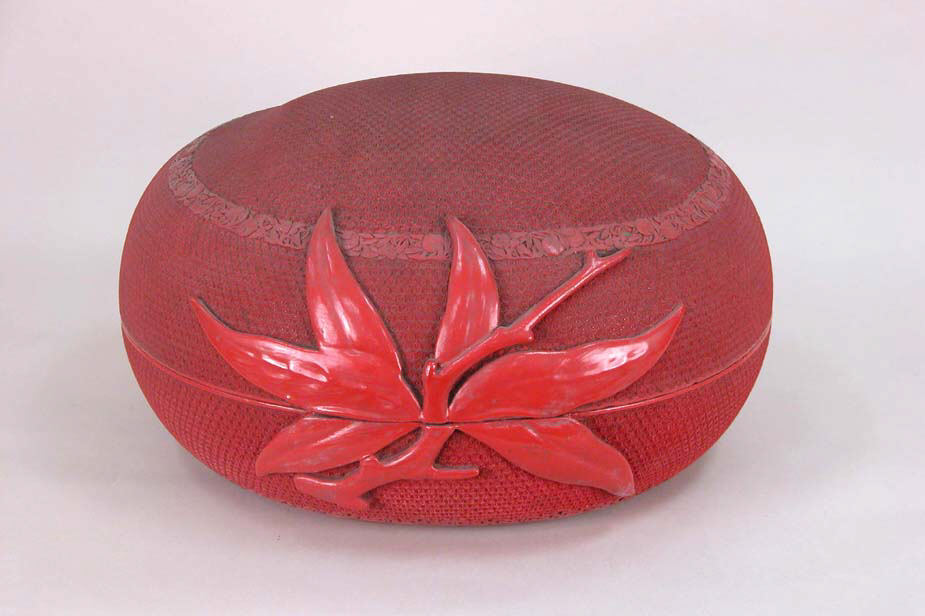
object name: pair of covered box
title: Pair of Heat-Shaped Covered Boxes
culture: chinese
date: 1701-1800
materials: lacquer